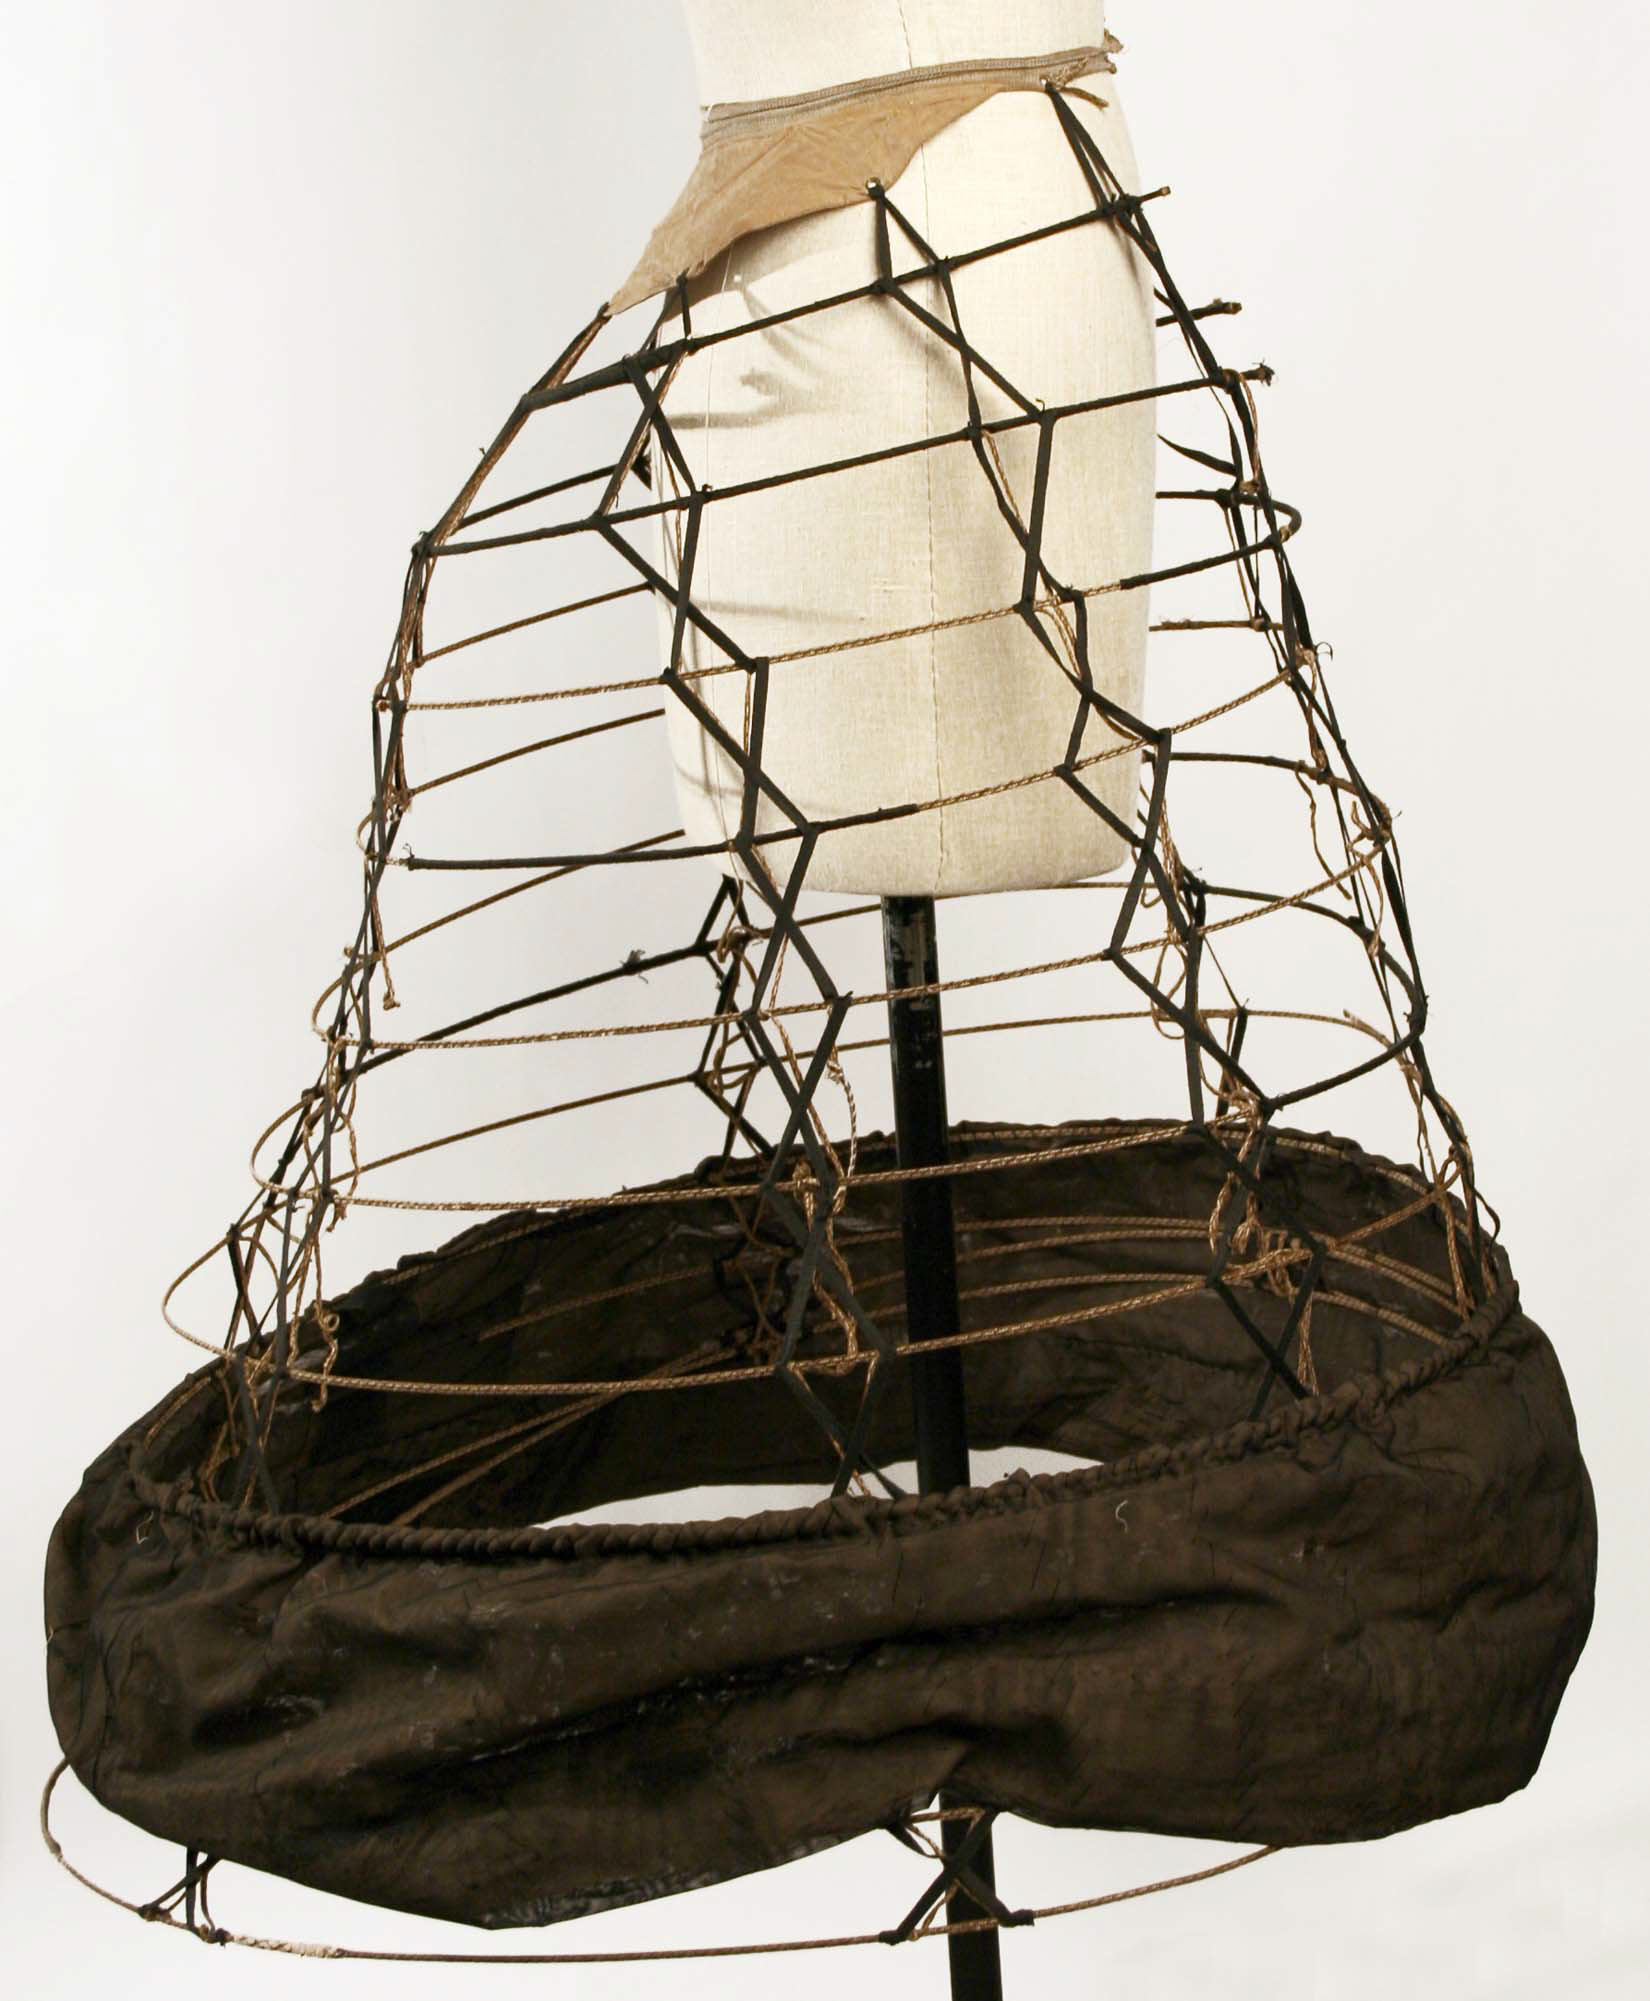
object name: crinoline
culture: american or european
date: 1850-1859